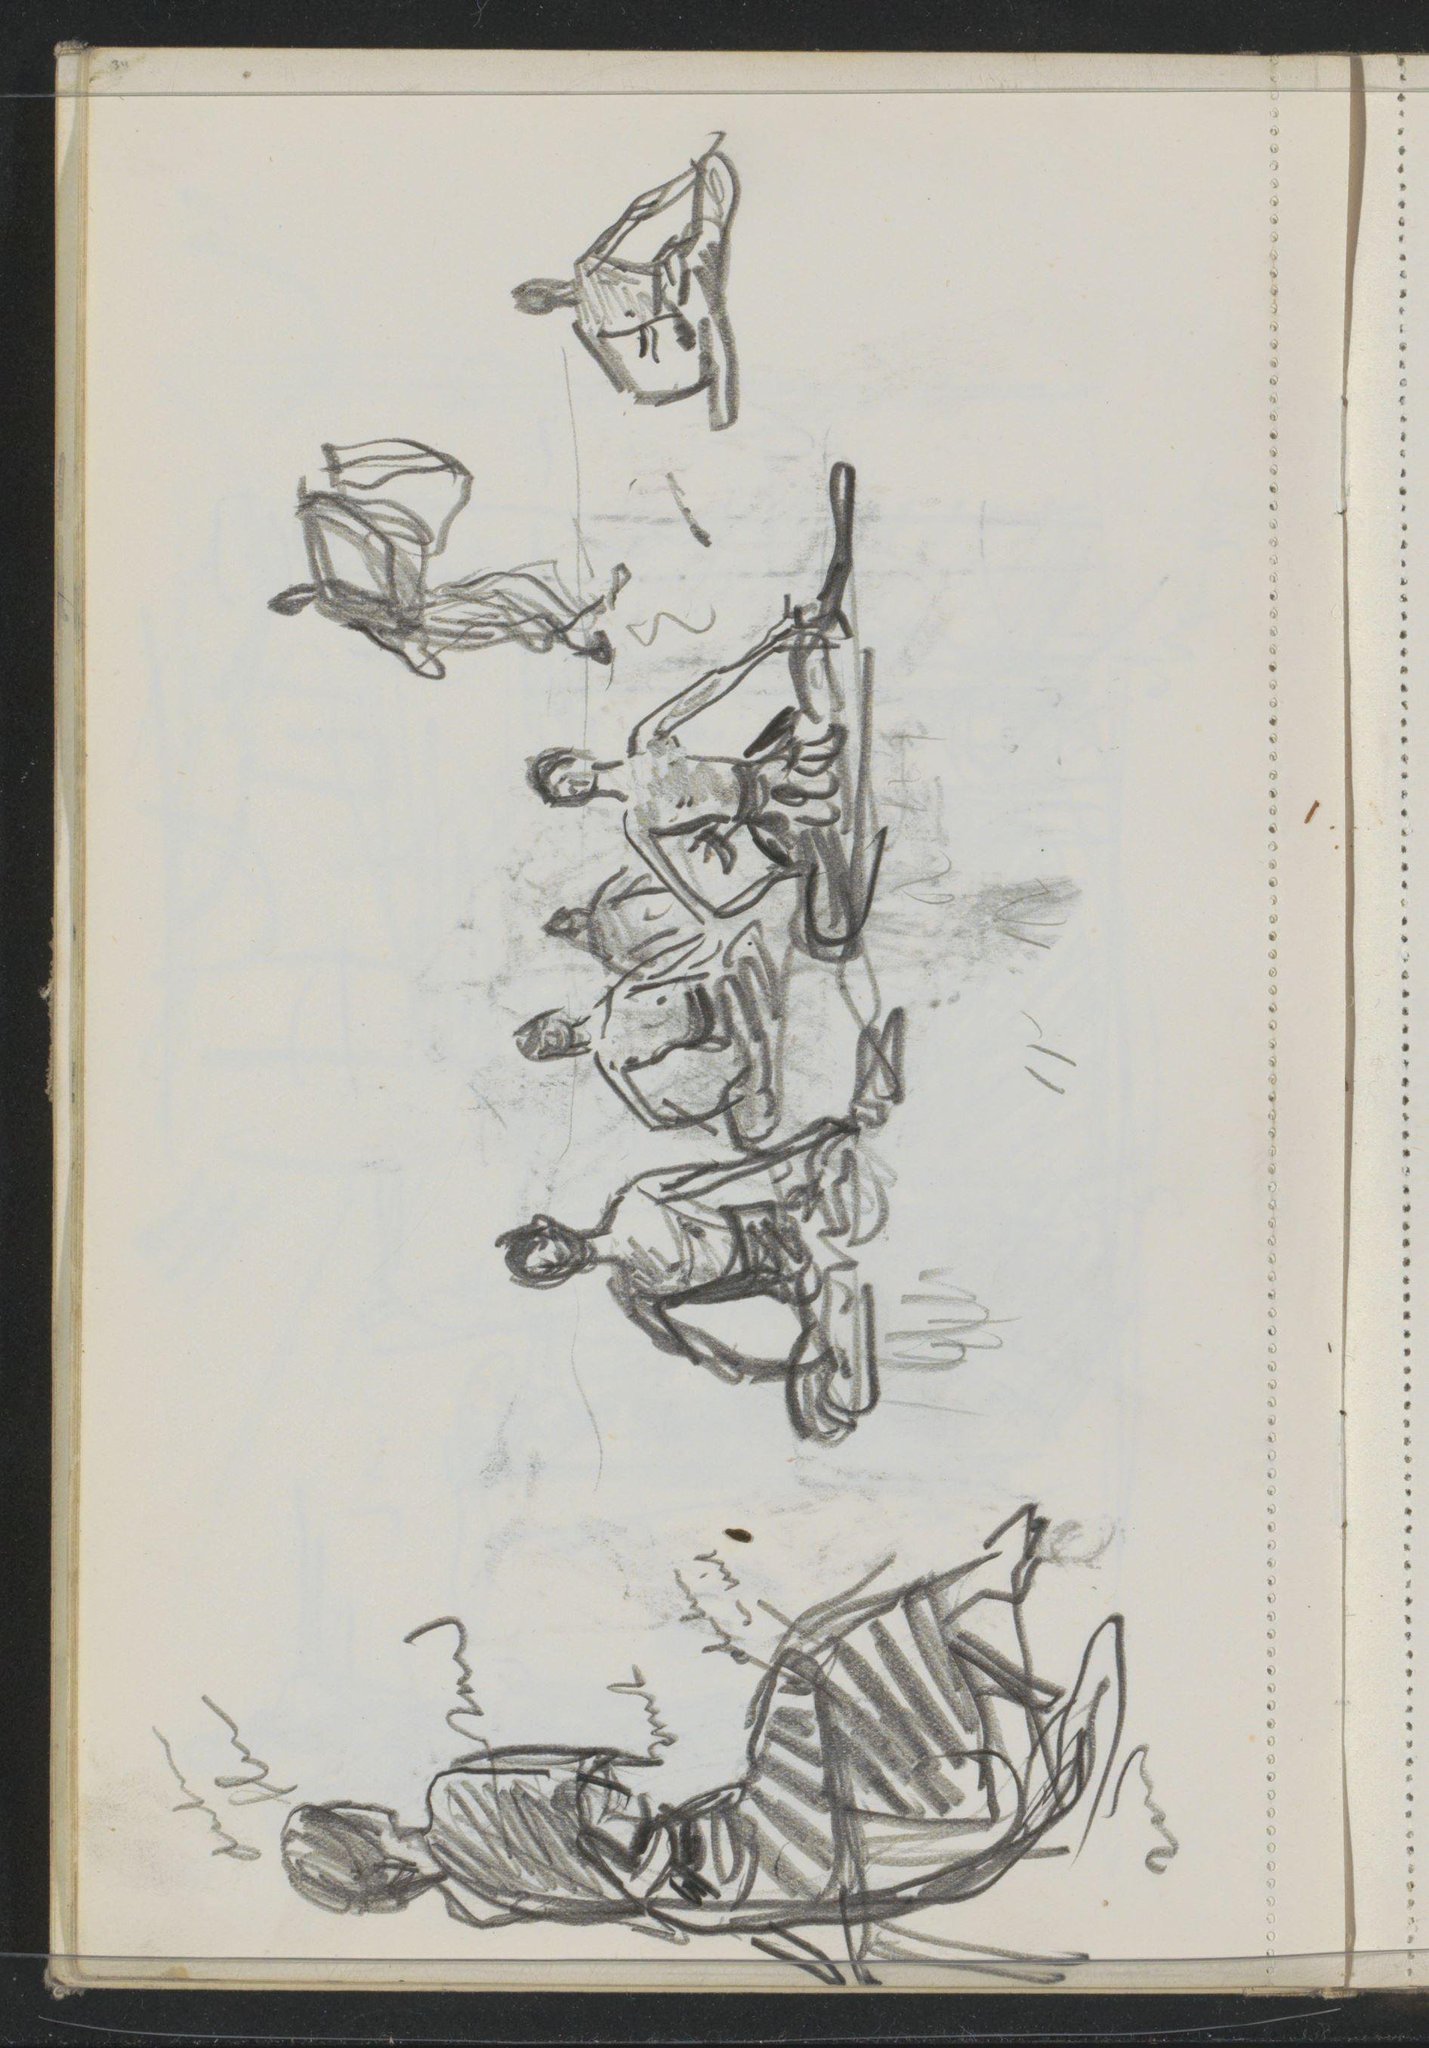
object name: sketchbook leaf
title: Mannelijke dansers in traditioneel kostuum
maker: marius bauer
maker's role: draughtsman, print maker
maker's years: 1867-1932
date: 1925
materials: paper, pencil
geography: indonesia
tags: folk costume, regional costume, group of men (folk dancing)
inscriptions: kleurnotitie, handgeschreven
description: Vermoedelijk dansers aan het Hof van Djokja. Pagina 34 uit een schetsboek met 74 bladen.